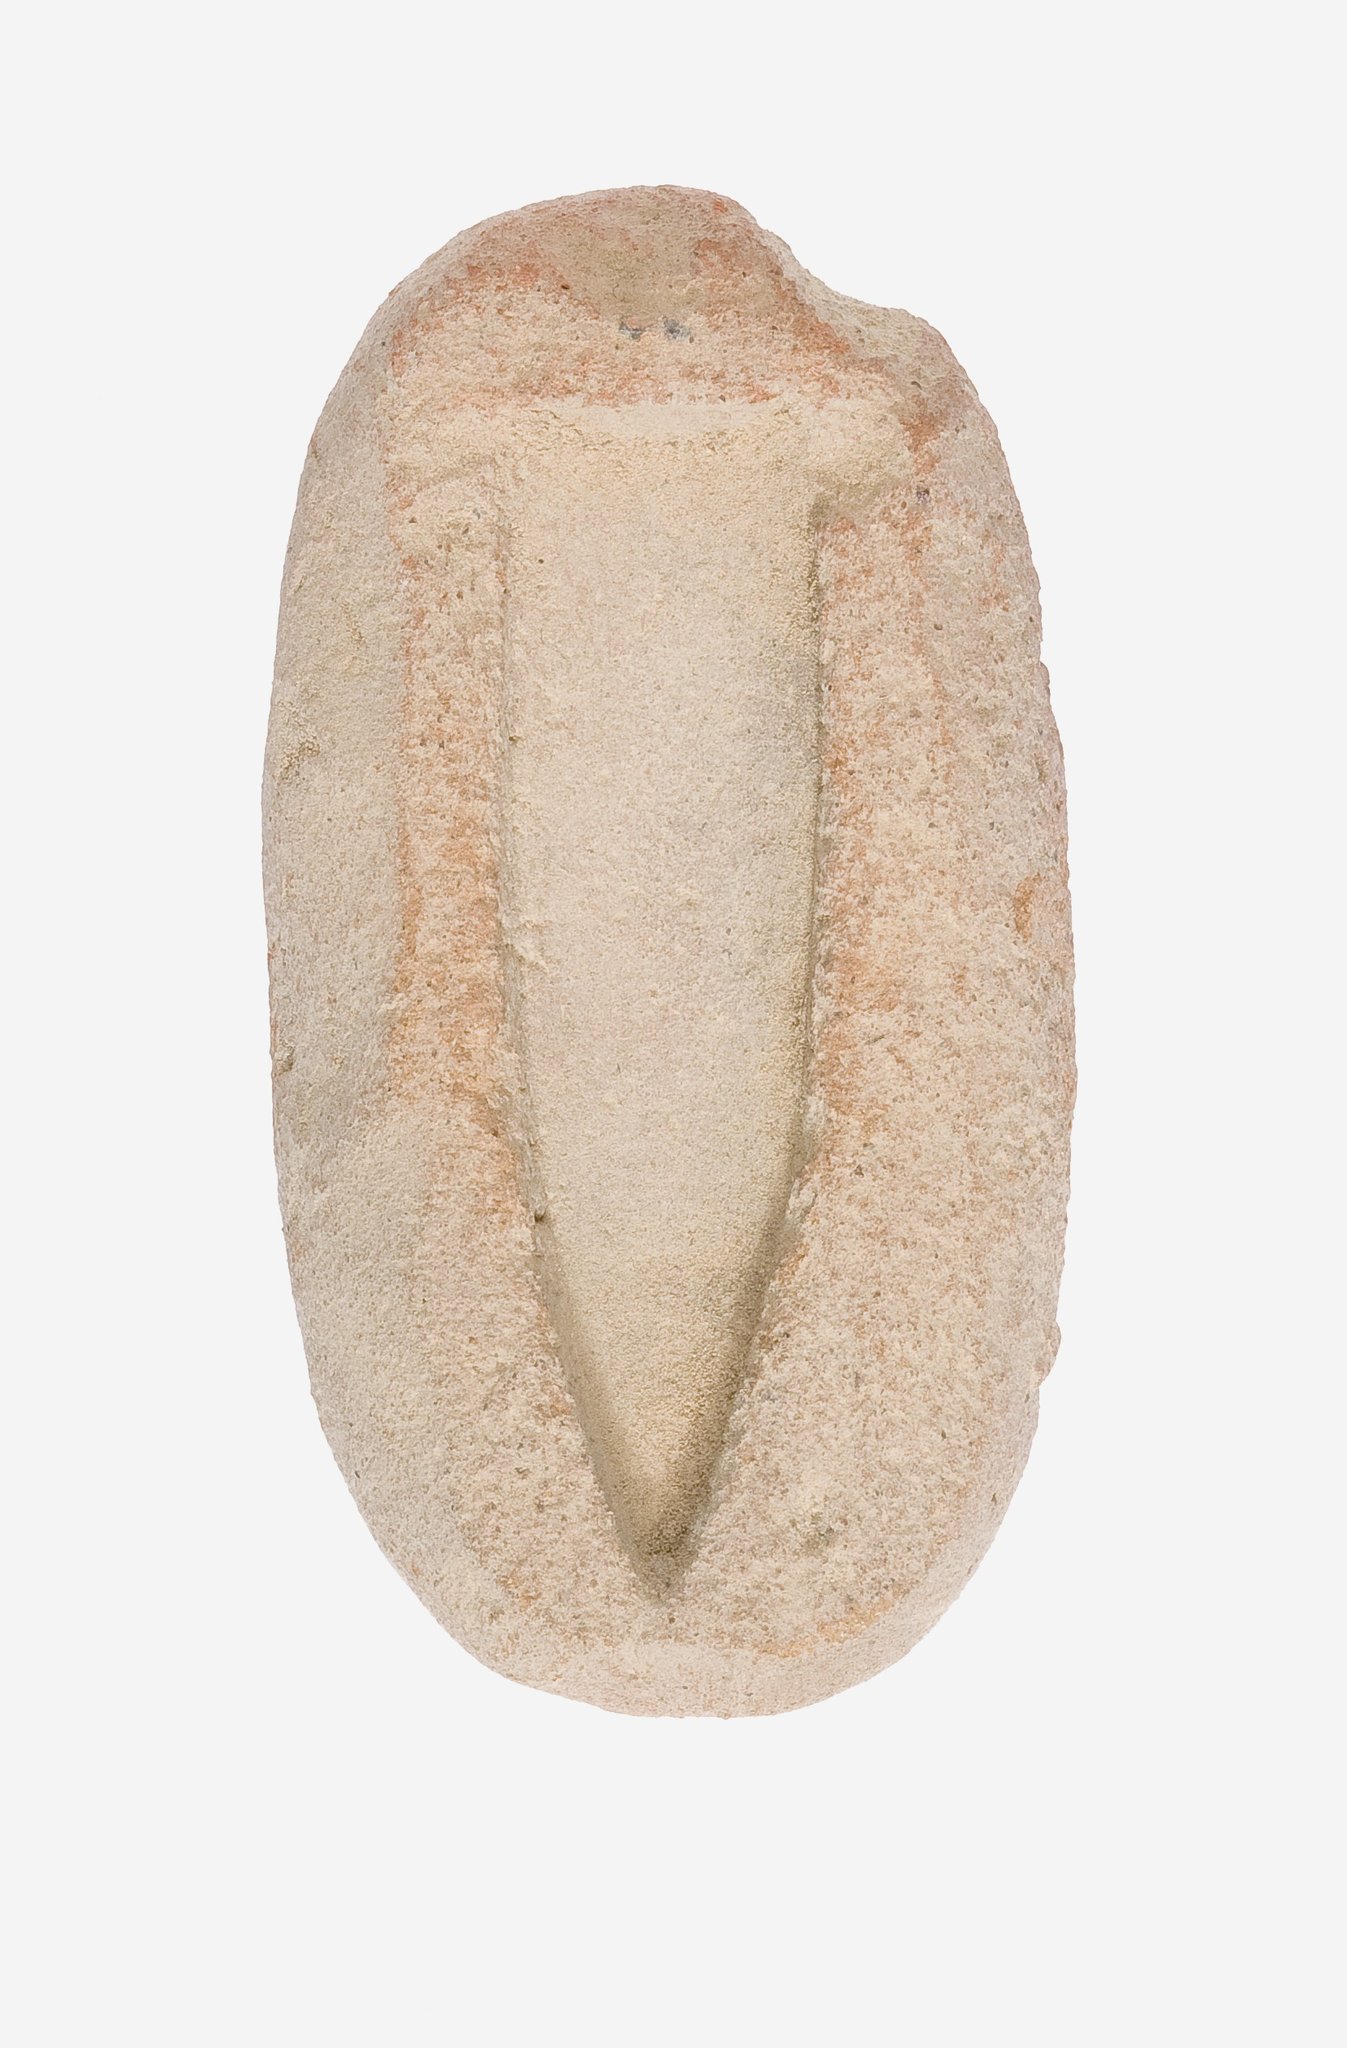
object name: mold, bead, lily petal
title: Mold of a Lily petal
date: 1390-1352 BCE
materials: pottery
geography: egypt